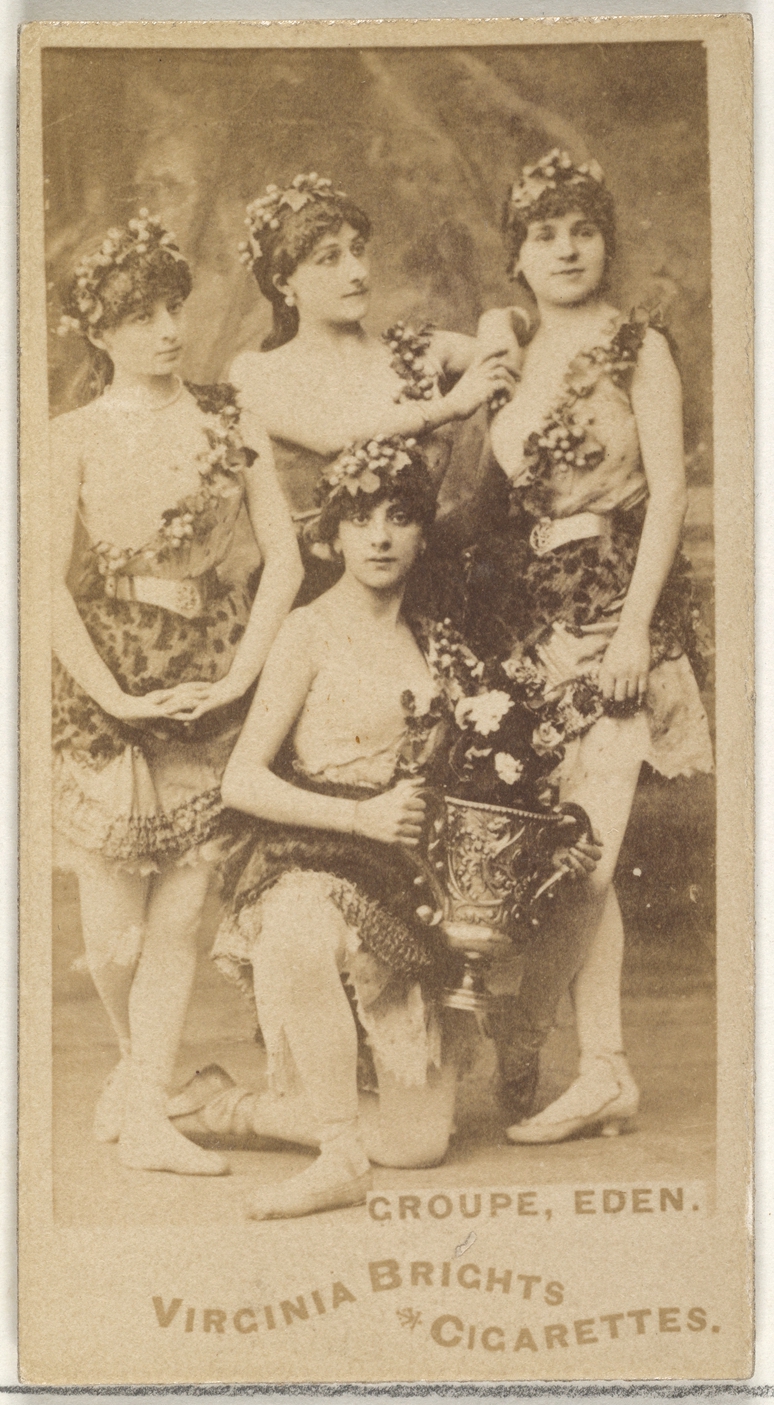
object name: photograph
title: Groupe, Eden, from the Actors and Actresses series (N45, Type 1) for Virginia Brights Cigarettes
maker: allen & ginter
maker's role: publisher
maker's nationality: american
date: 1888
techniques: albumen silver print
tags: portraits,women,actresses,vases